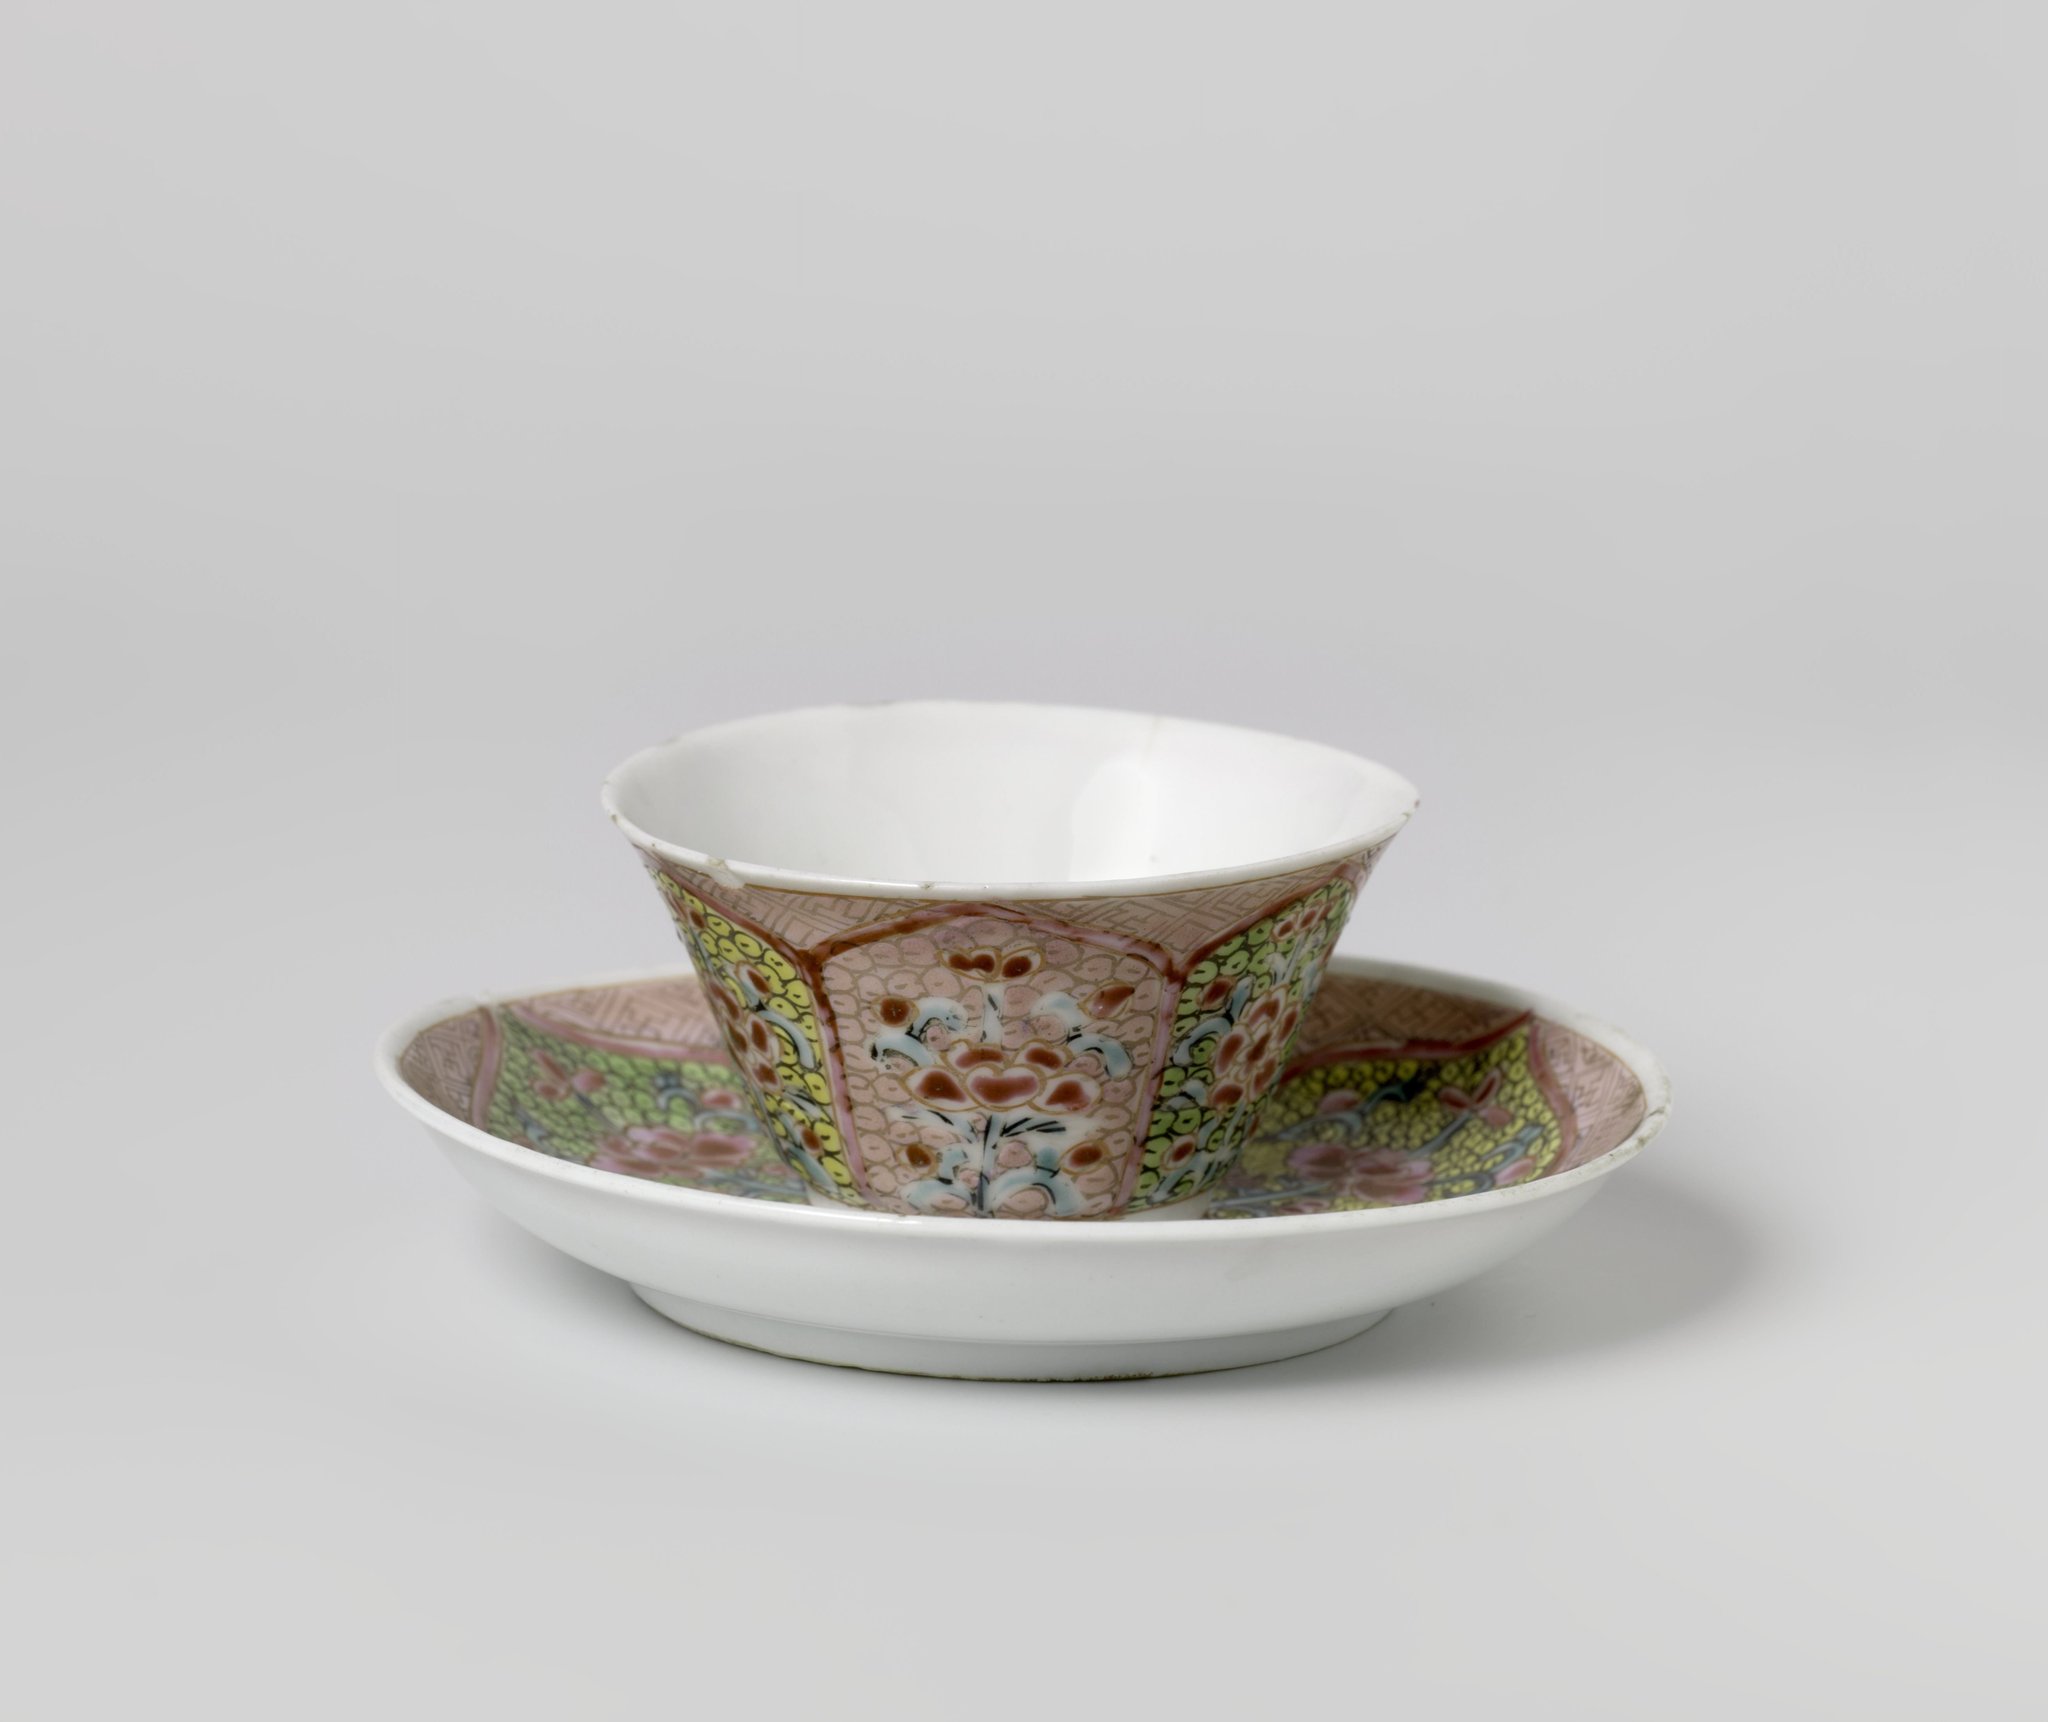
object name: kop en schotel, kop en schotel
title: Cup and saucer with floral scrolls in petal-shaped panels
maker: Anonymous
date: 1725-1749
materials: glaze, paint, porcelain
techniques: firing, turning, vitrification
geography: china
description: Kop en schotel van porselein met rechte, uitlopende wand, beschilderd op het glazuur in blauw, rood, groen, geel en zwart. Op het plat van de schotel vakken in de vorm van een bloem, in het centrum een lotus en in de bloembladvormige vakken bloemranken op verschillend gekleurd servetwerk; op de rand een swastika-patroon. De kop met dezelfde decoratie. Een barst in de wand van de schotel en enkele in de wand van de kop. Famille rose.